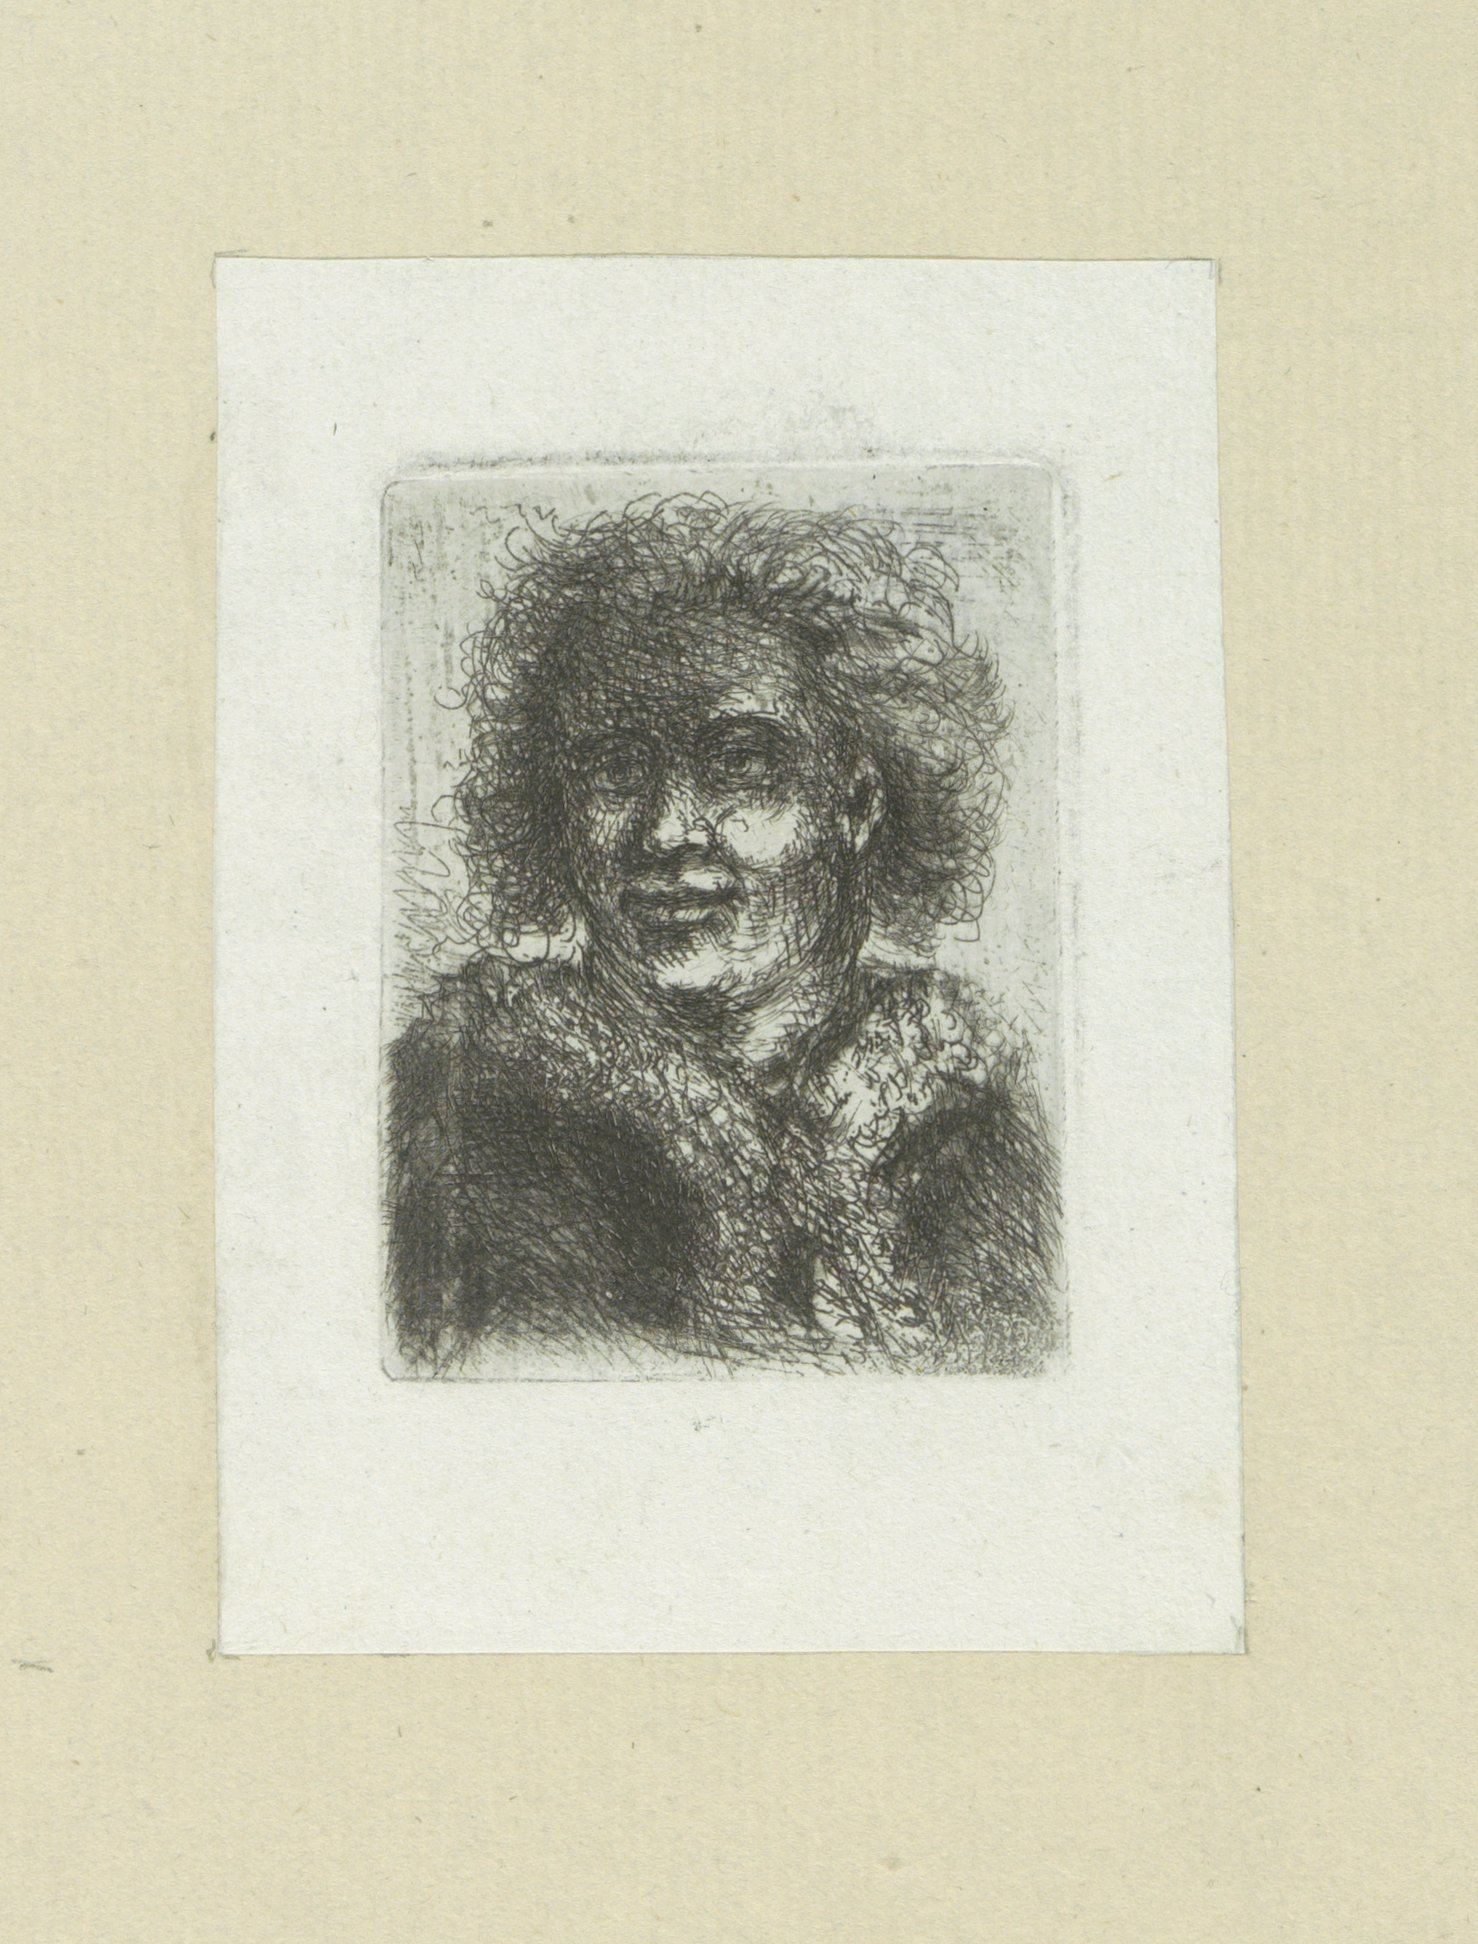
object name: album leaf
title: Man met bontkraag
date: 1802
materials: paper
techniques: drypoint, etching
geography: london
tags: morphology of human expression (+ adult male (human being))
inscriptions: collector's mark: ‘RIJKS / MUSM’, collector's mark: ‘B’